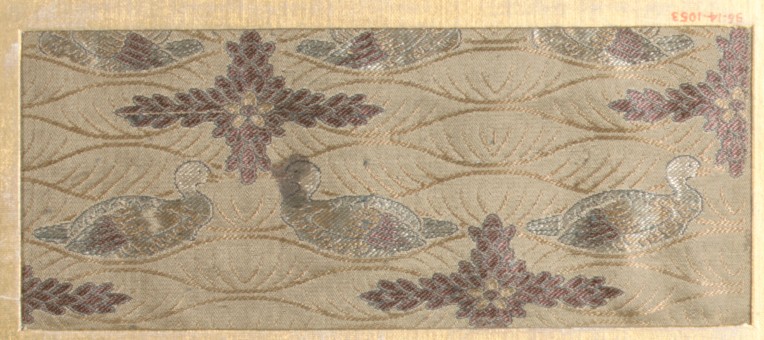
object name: piece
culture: japanese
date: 1701-1900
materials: silk